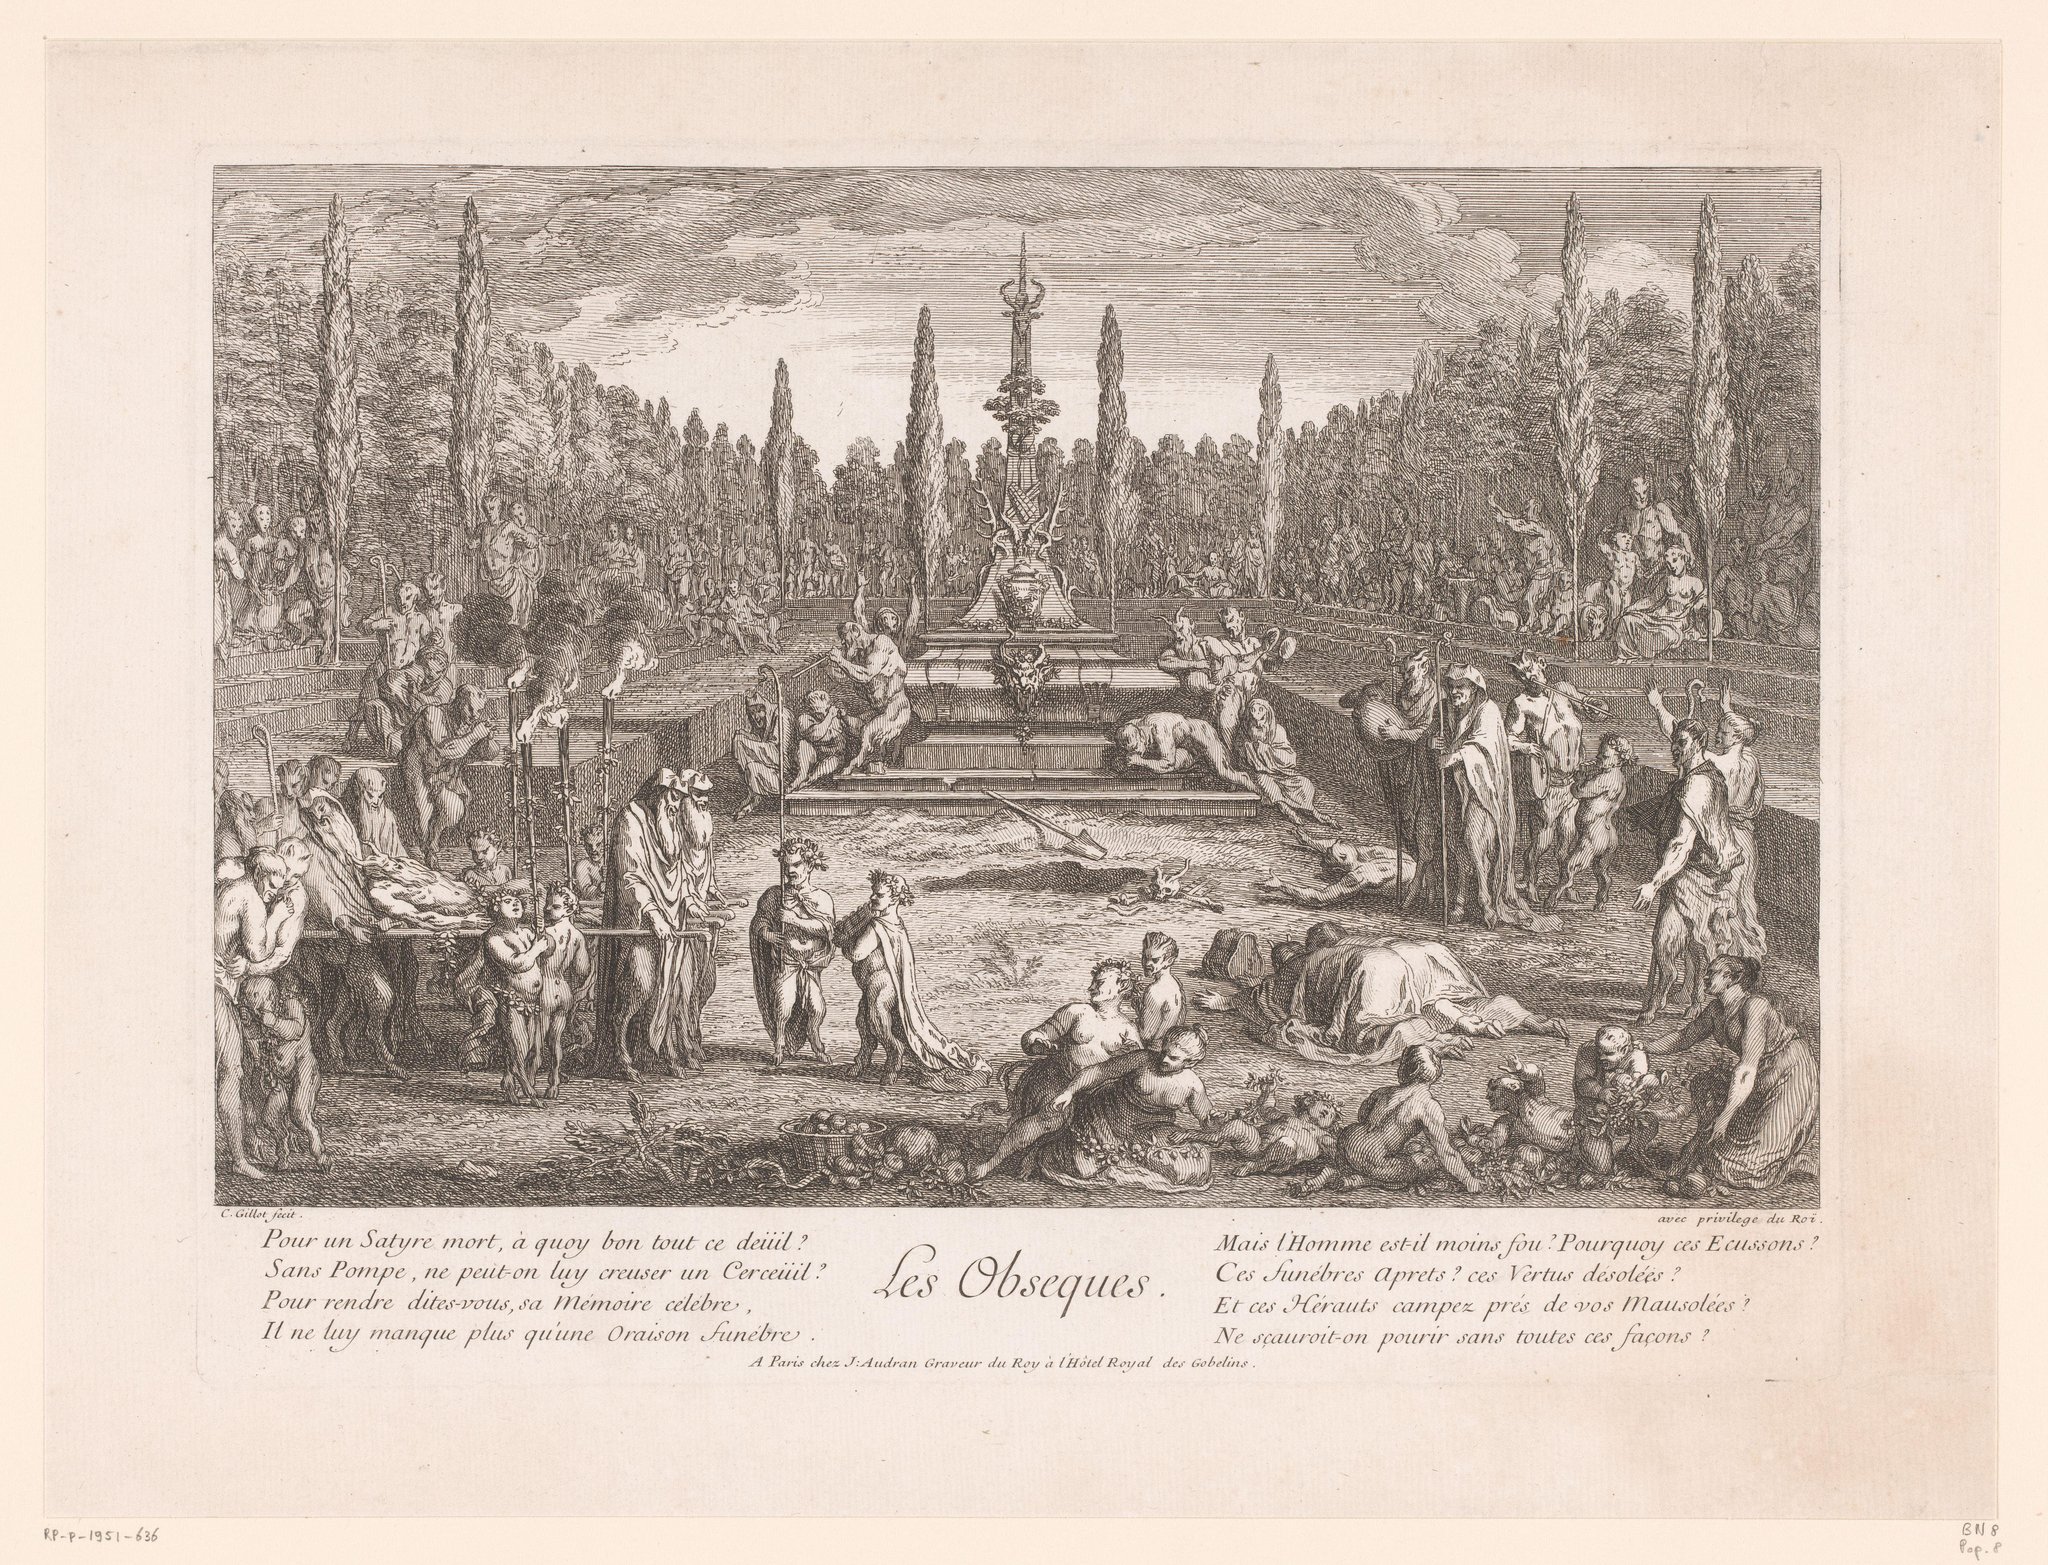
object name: print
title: Les Obseques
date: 1683-1722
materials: paper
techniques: engraving, etching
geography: paris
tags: satyr(s) (in general), funerary ceremonial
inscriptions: collector's mark: Lugt 2228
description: Maakt deel uit van een vierdelige serie met scènes uit het leven van saters.